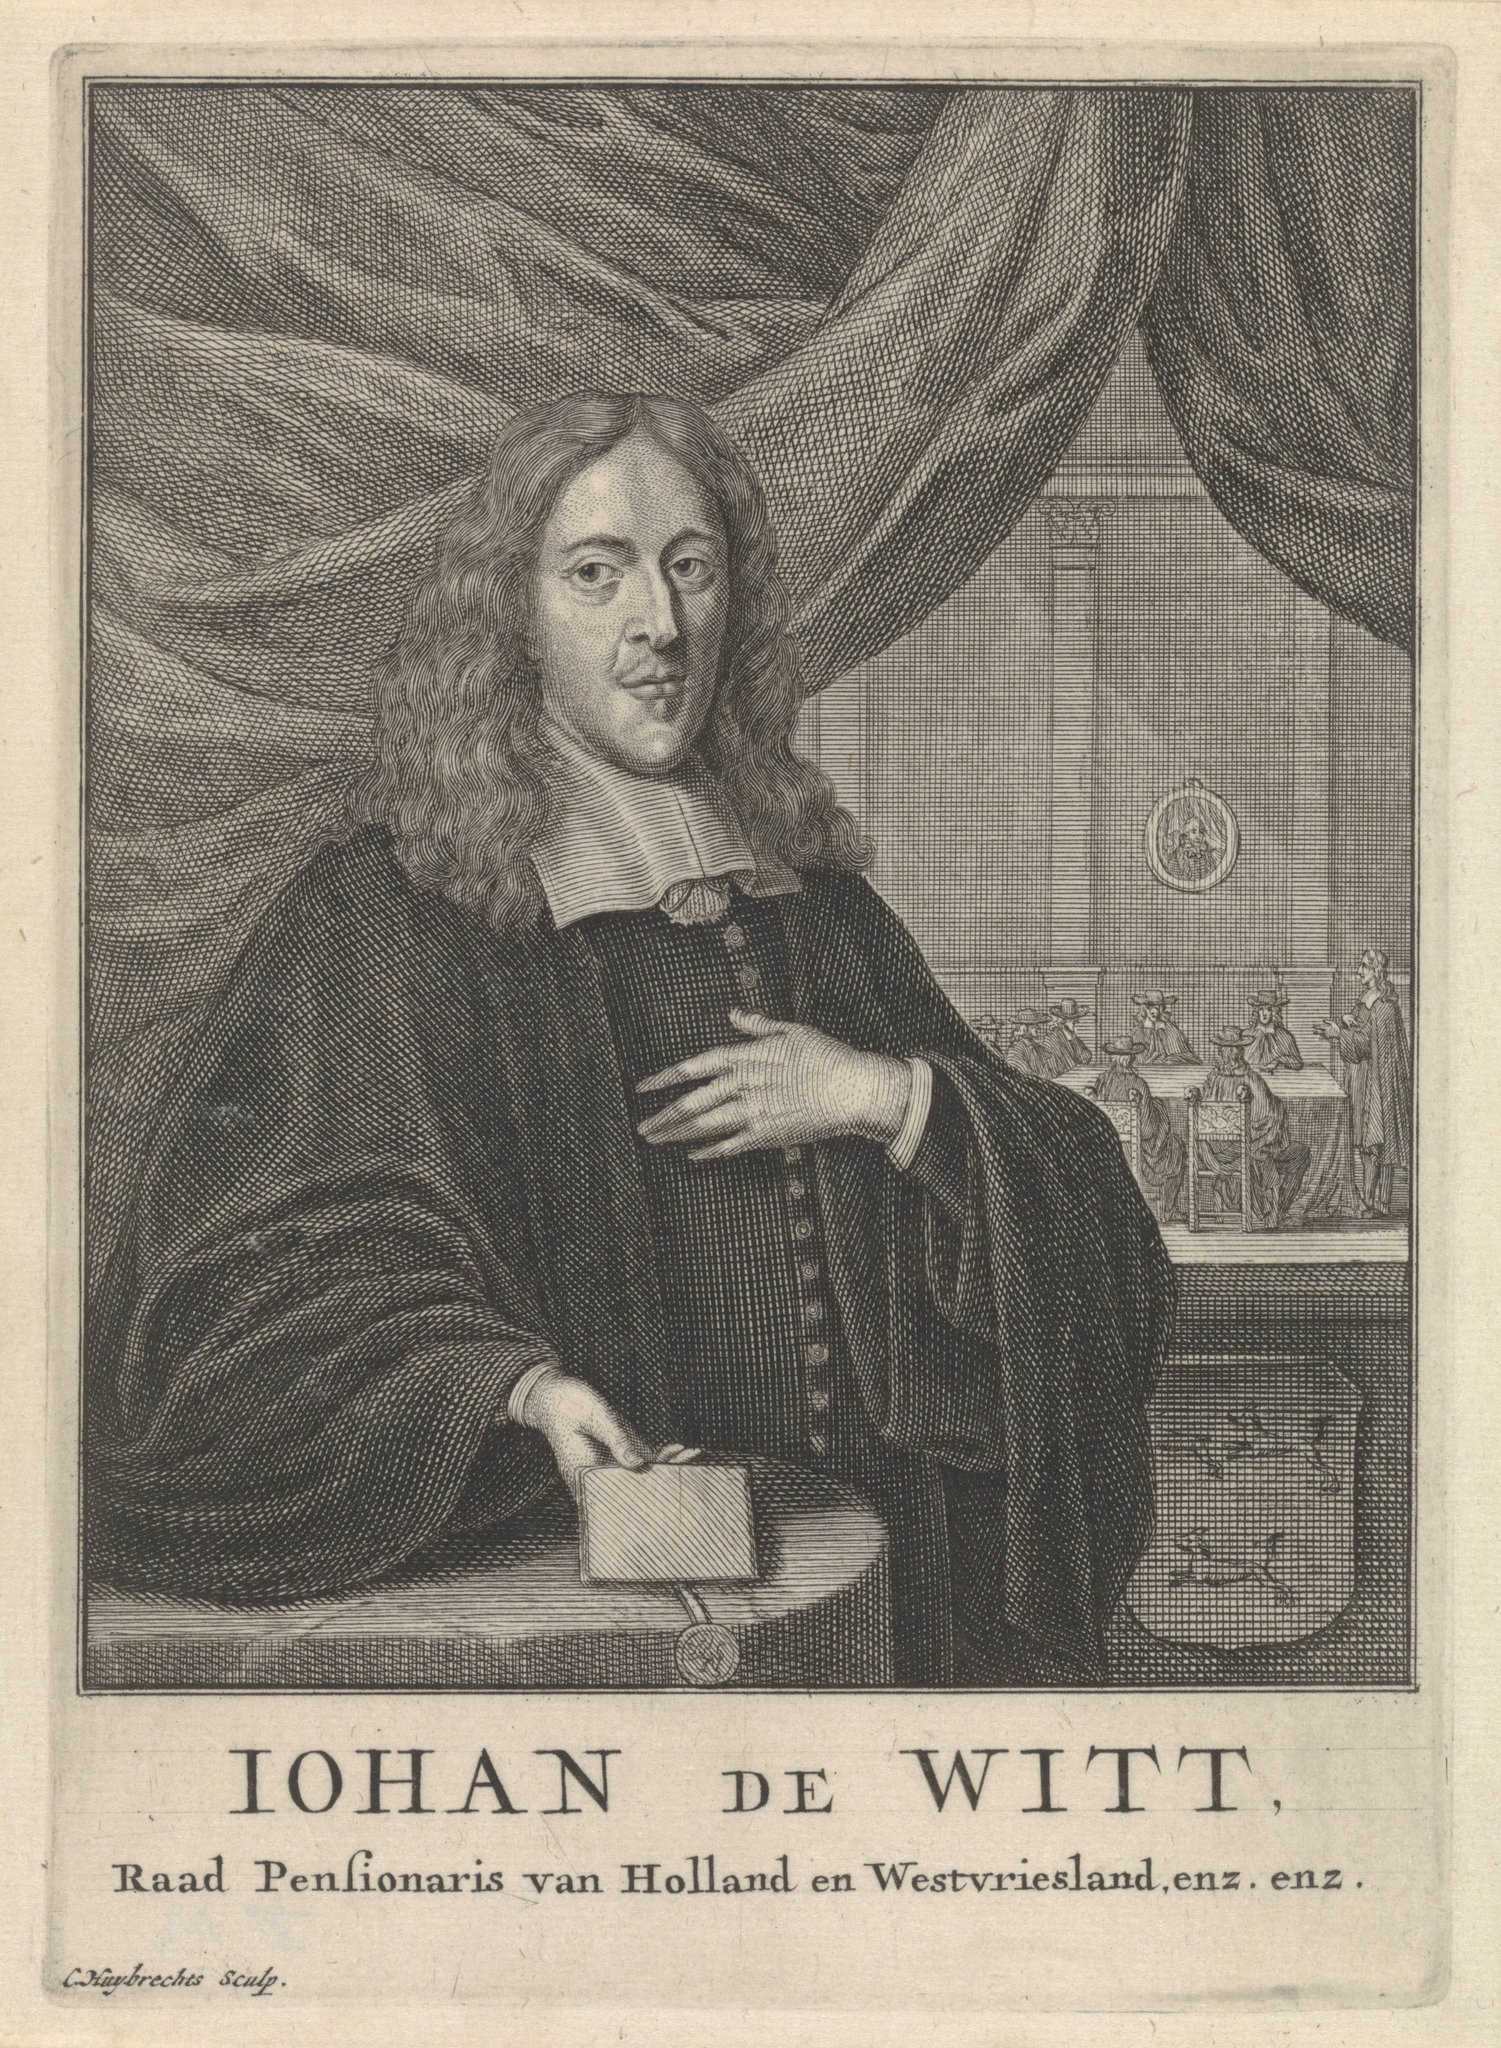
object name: print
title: Portret van Johan de Witt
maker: cornelis huyberts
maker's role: print maker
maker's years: 1669-1709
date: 1689-1712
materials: paper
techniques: engraving, etching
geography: amsterdam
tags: the hague, politician, johan de witt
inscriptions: collector's mark: Lugt 2228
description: Johan de Witt ten halven lijve naar rechts. De Witt toont een document met zegel. Rechtsonder zijn familiewapen. Rechtsachter een ruimte met een vergadering van mannen om een tafel en een portret aan de muur.